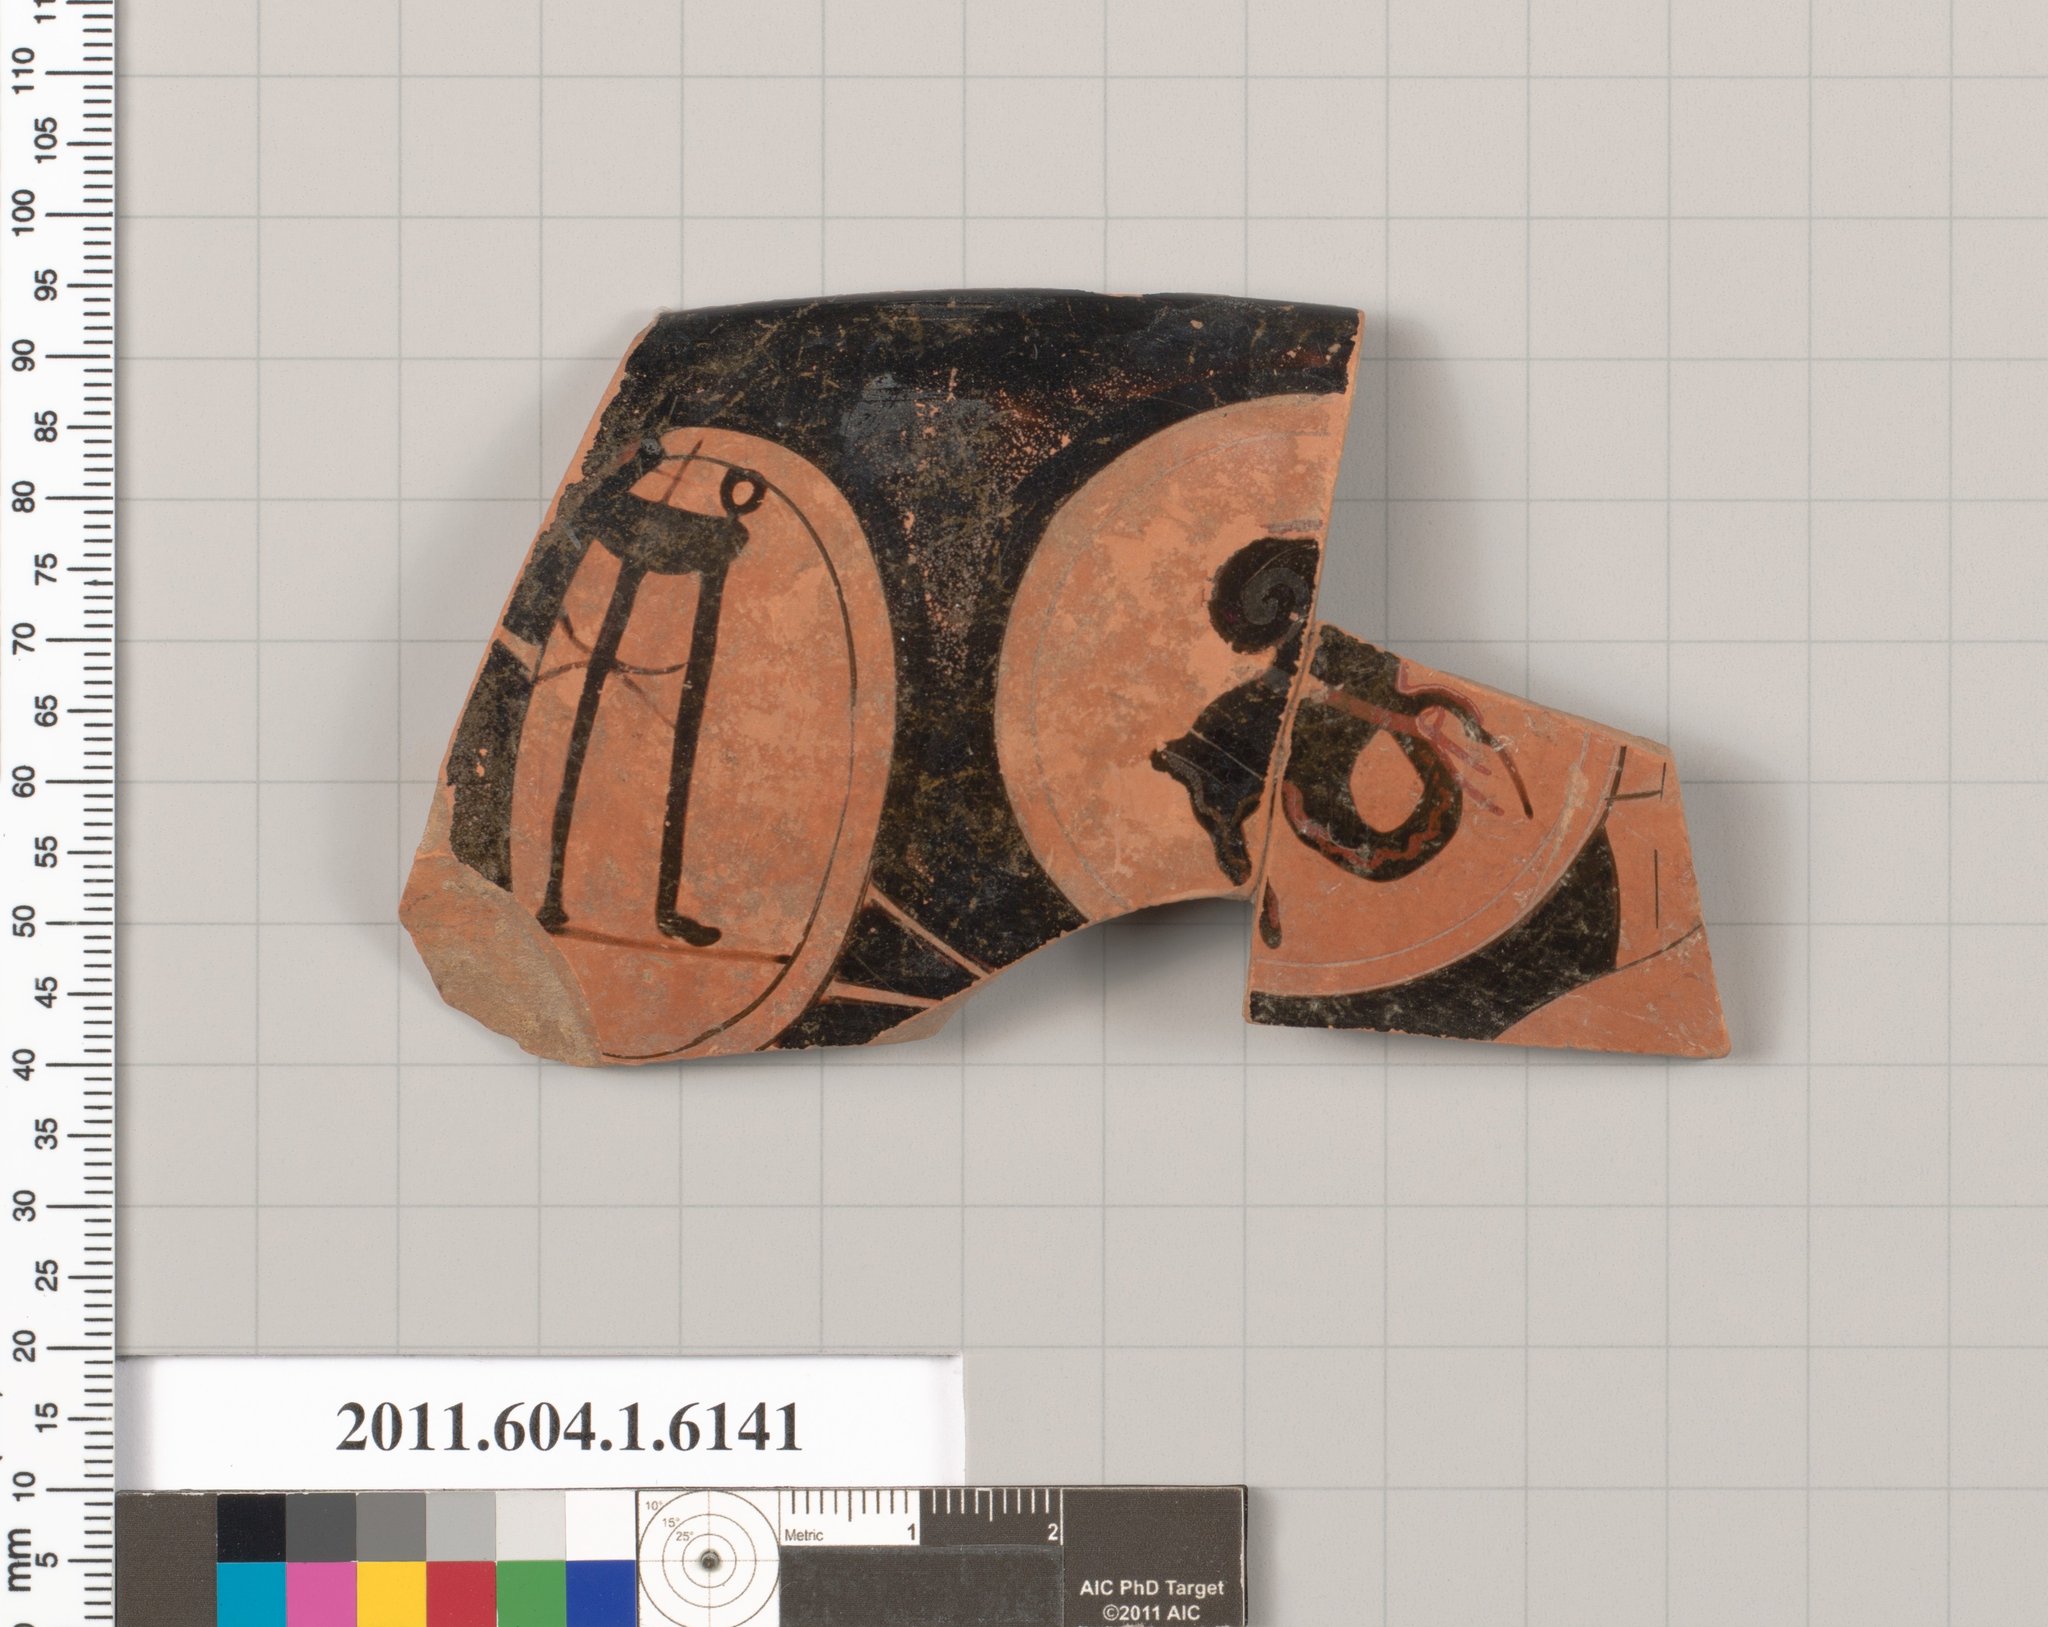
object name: kylix fragment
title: Terracotta rim fragment of a kylix (drinking cup)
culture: greek, attic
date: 520-500 BCE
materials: terracotta